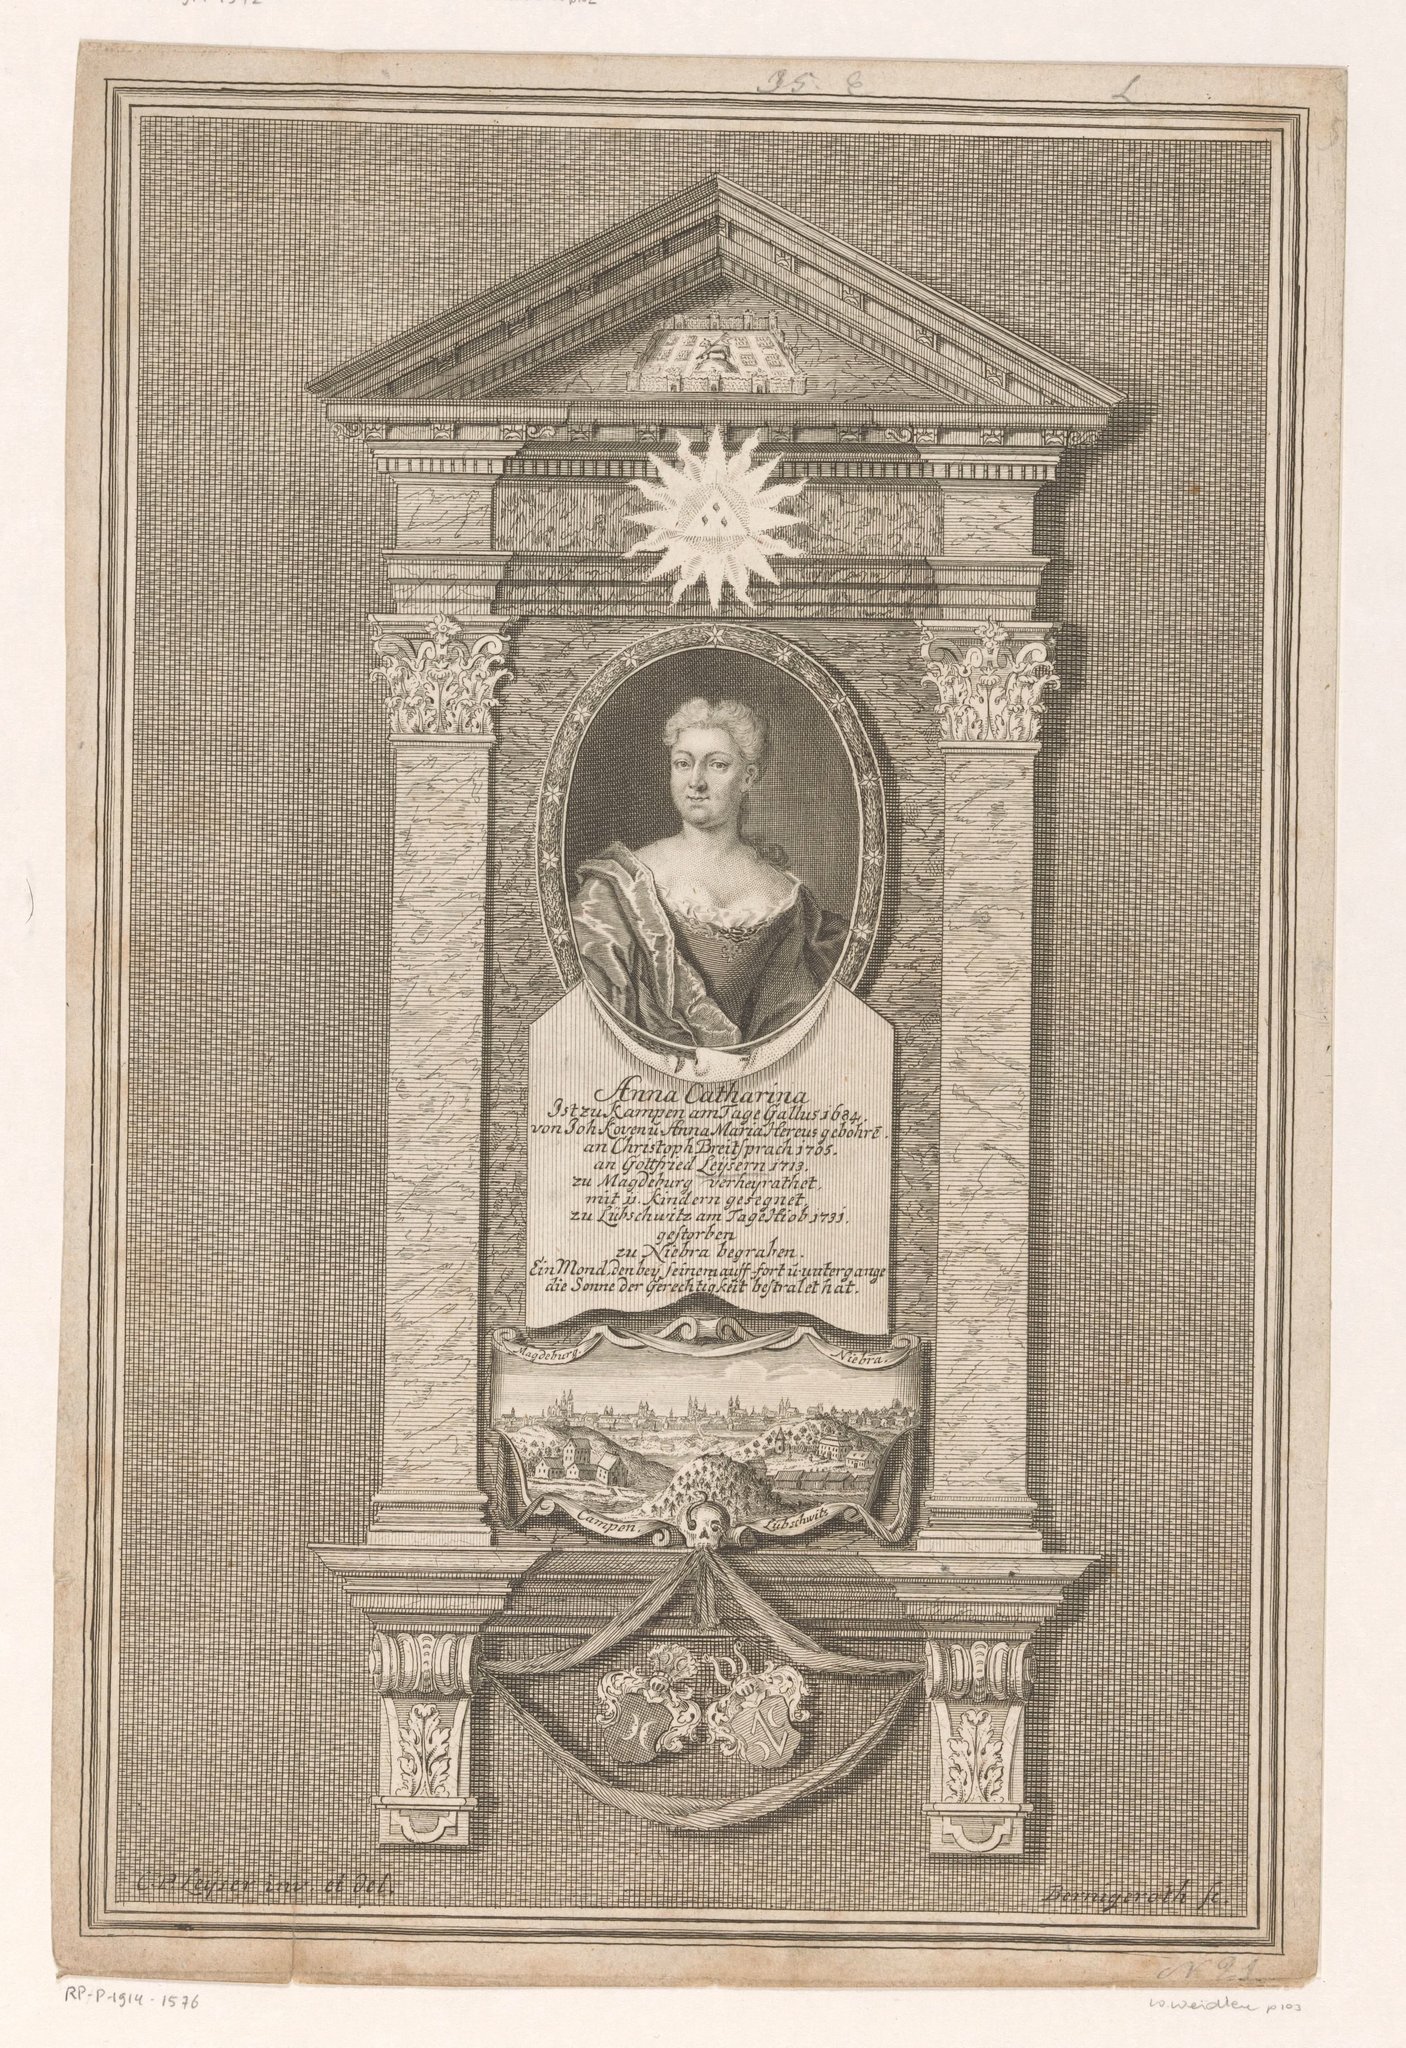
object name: print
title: Portret van Anna Catharina Leyser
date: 1731-1733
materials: paper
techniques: engraving, etching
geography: leipzig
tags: the new jerusalem, city-view in general; 'veduta', historical persons - bb - woman, armorial bearing, heraldry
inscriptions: collector's mark: Lugt 2228